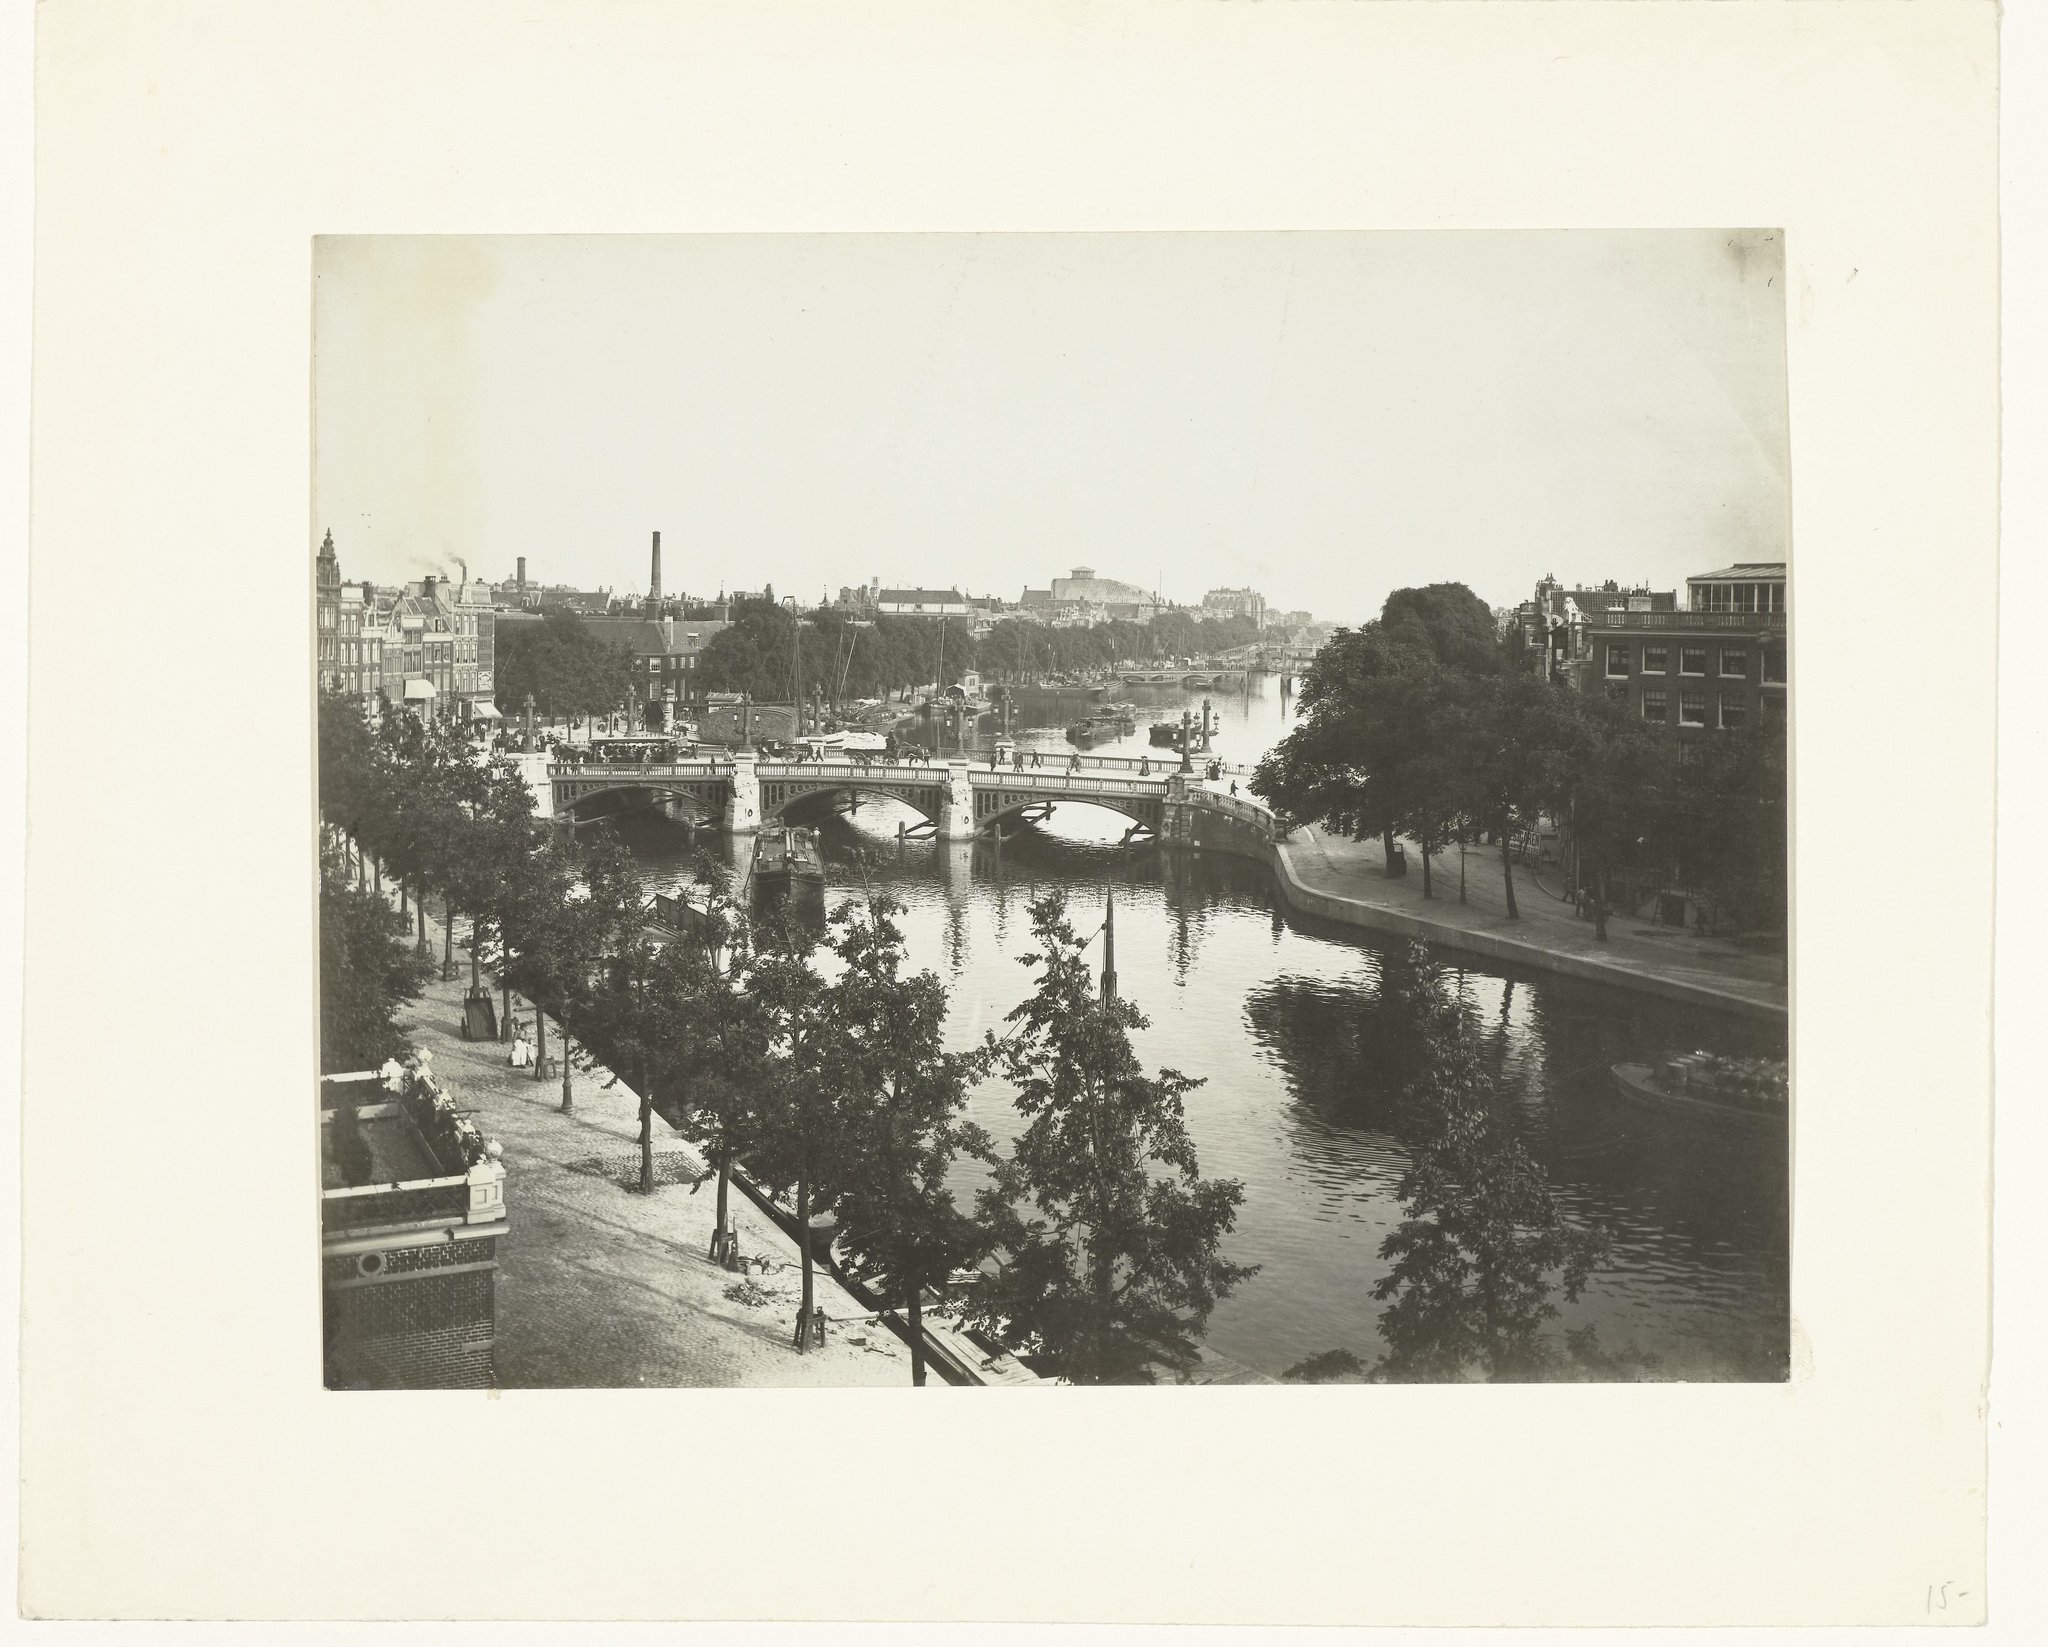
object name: photograph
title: Amsterdam, amstel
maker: Anonymous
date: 1880-1920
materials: paper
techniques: matte daylight collodion silver print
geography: amsterdam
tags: canals, waters (in city), bridge in city across river, canal, etc.